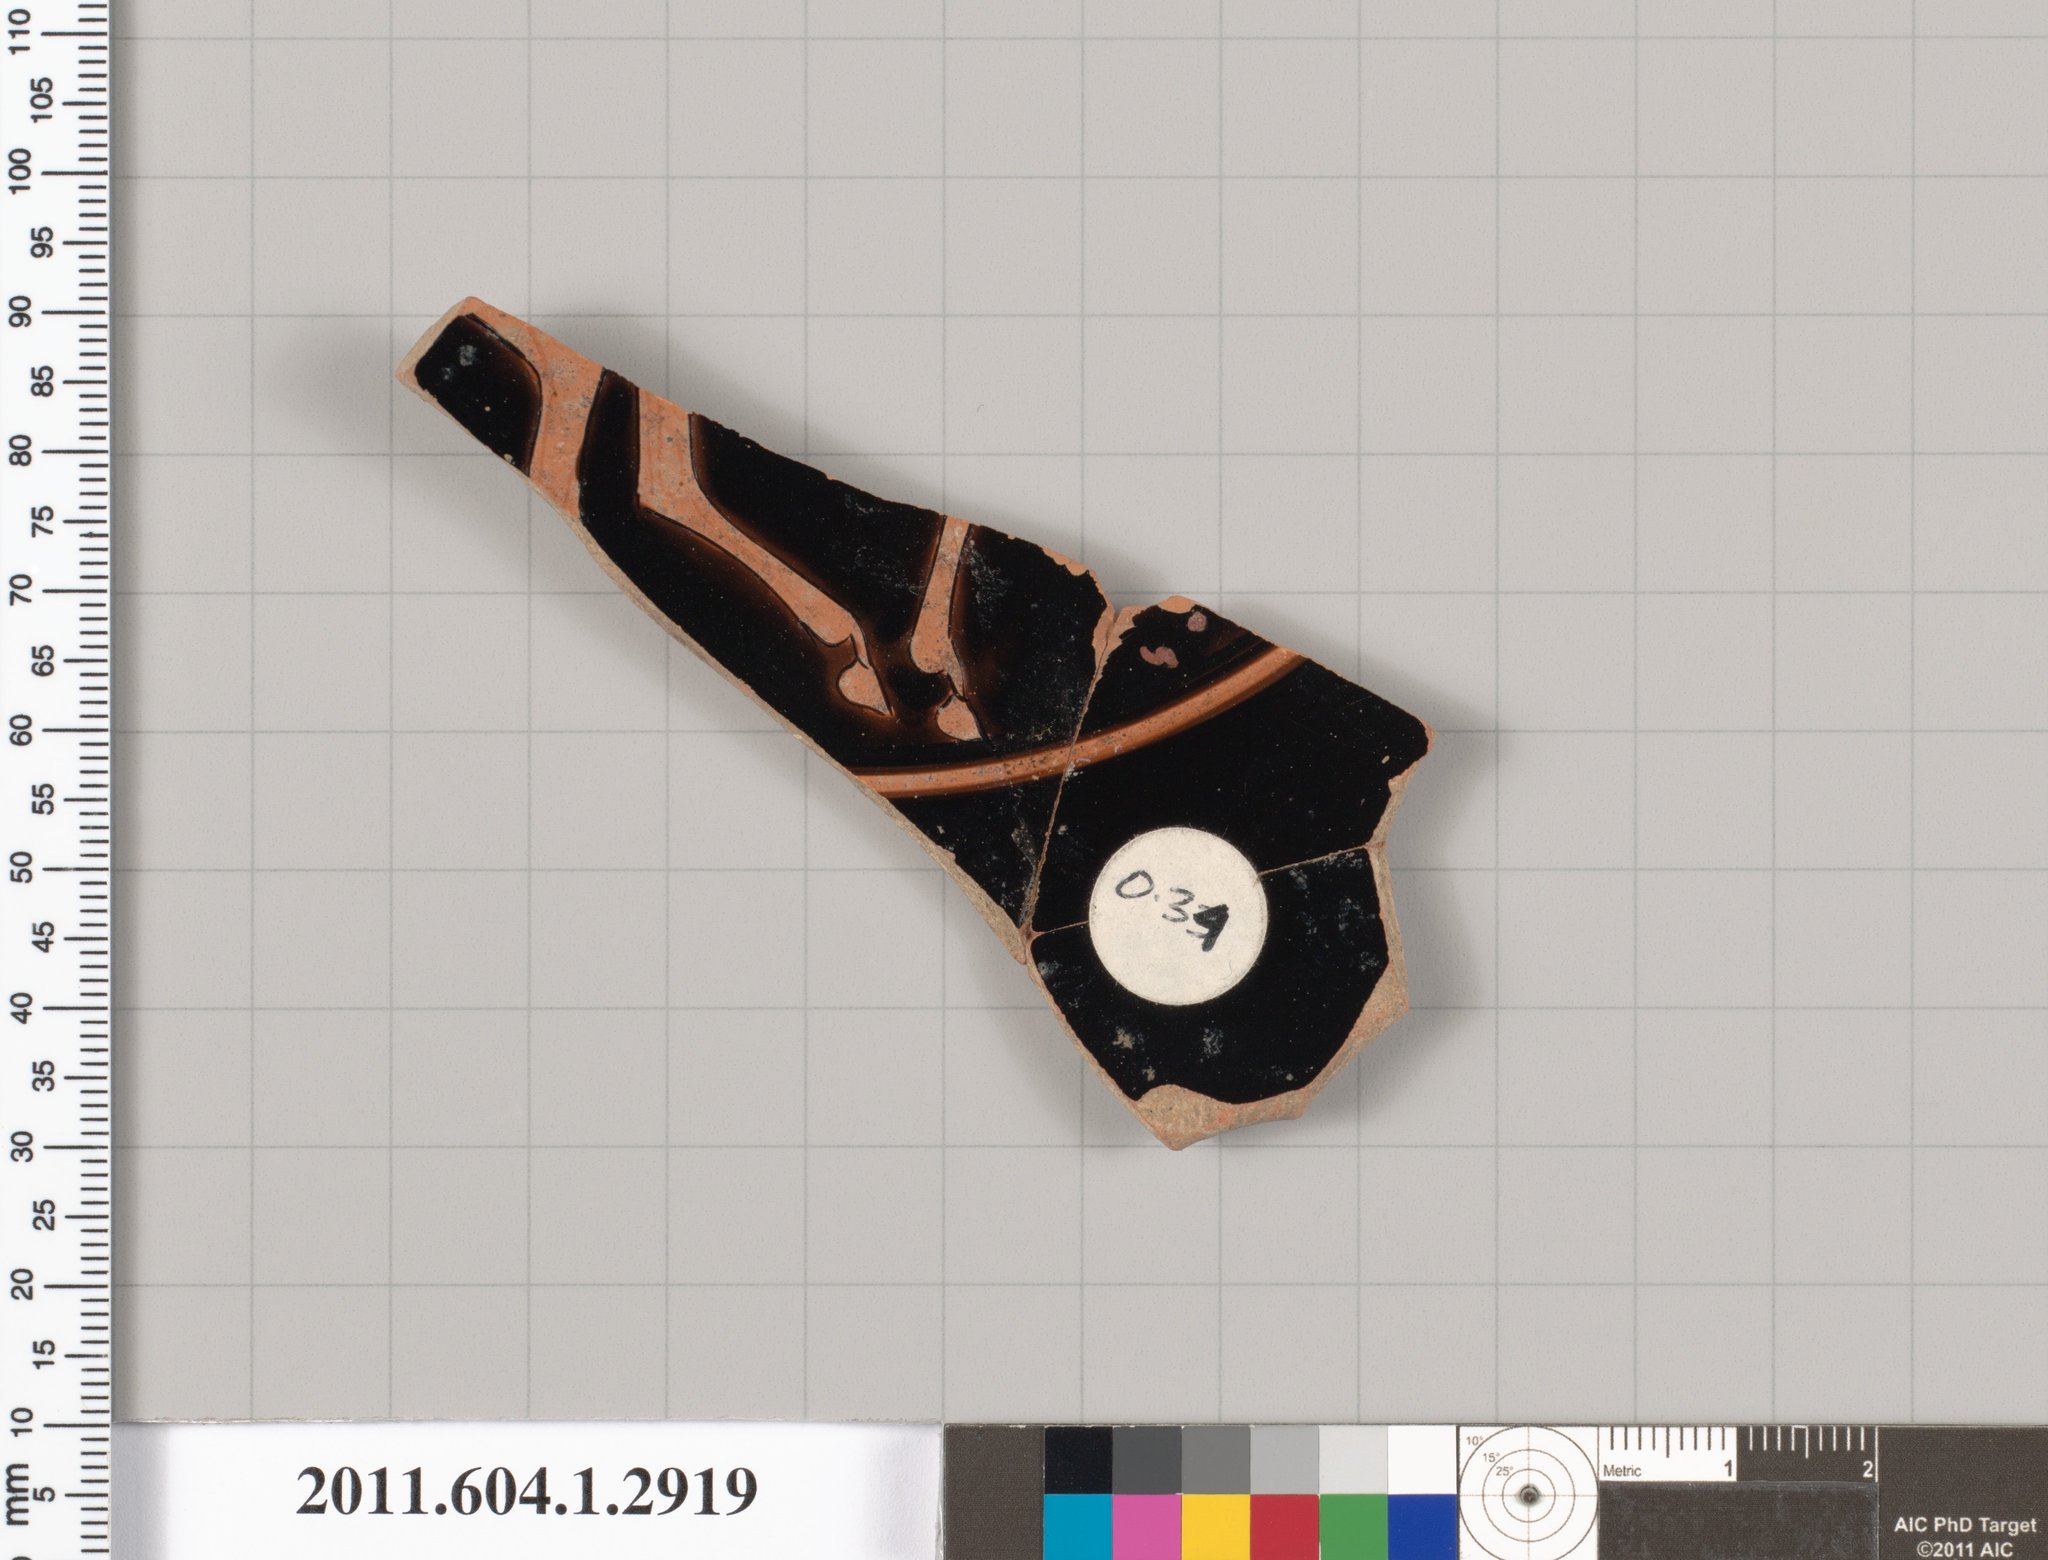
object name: kylix fragment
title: Terracotta fragment of a kylix (drinking cup)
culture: greek, attic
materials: terracotta